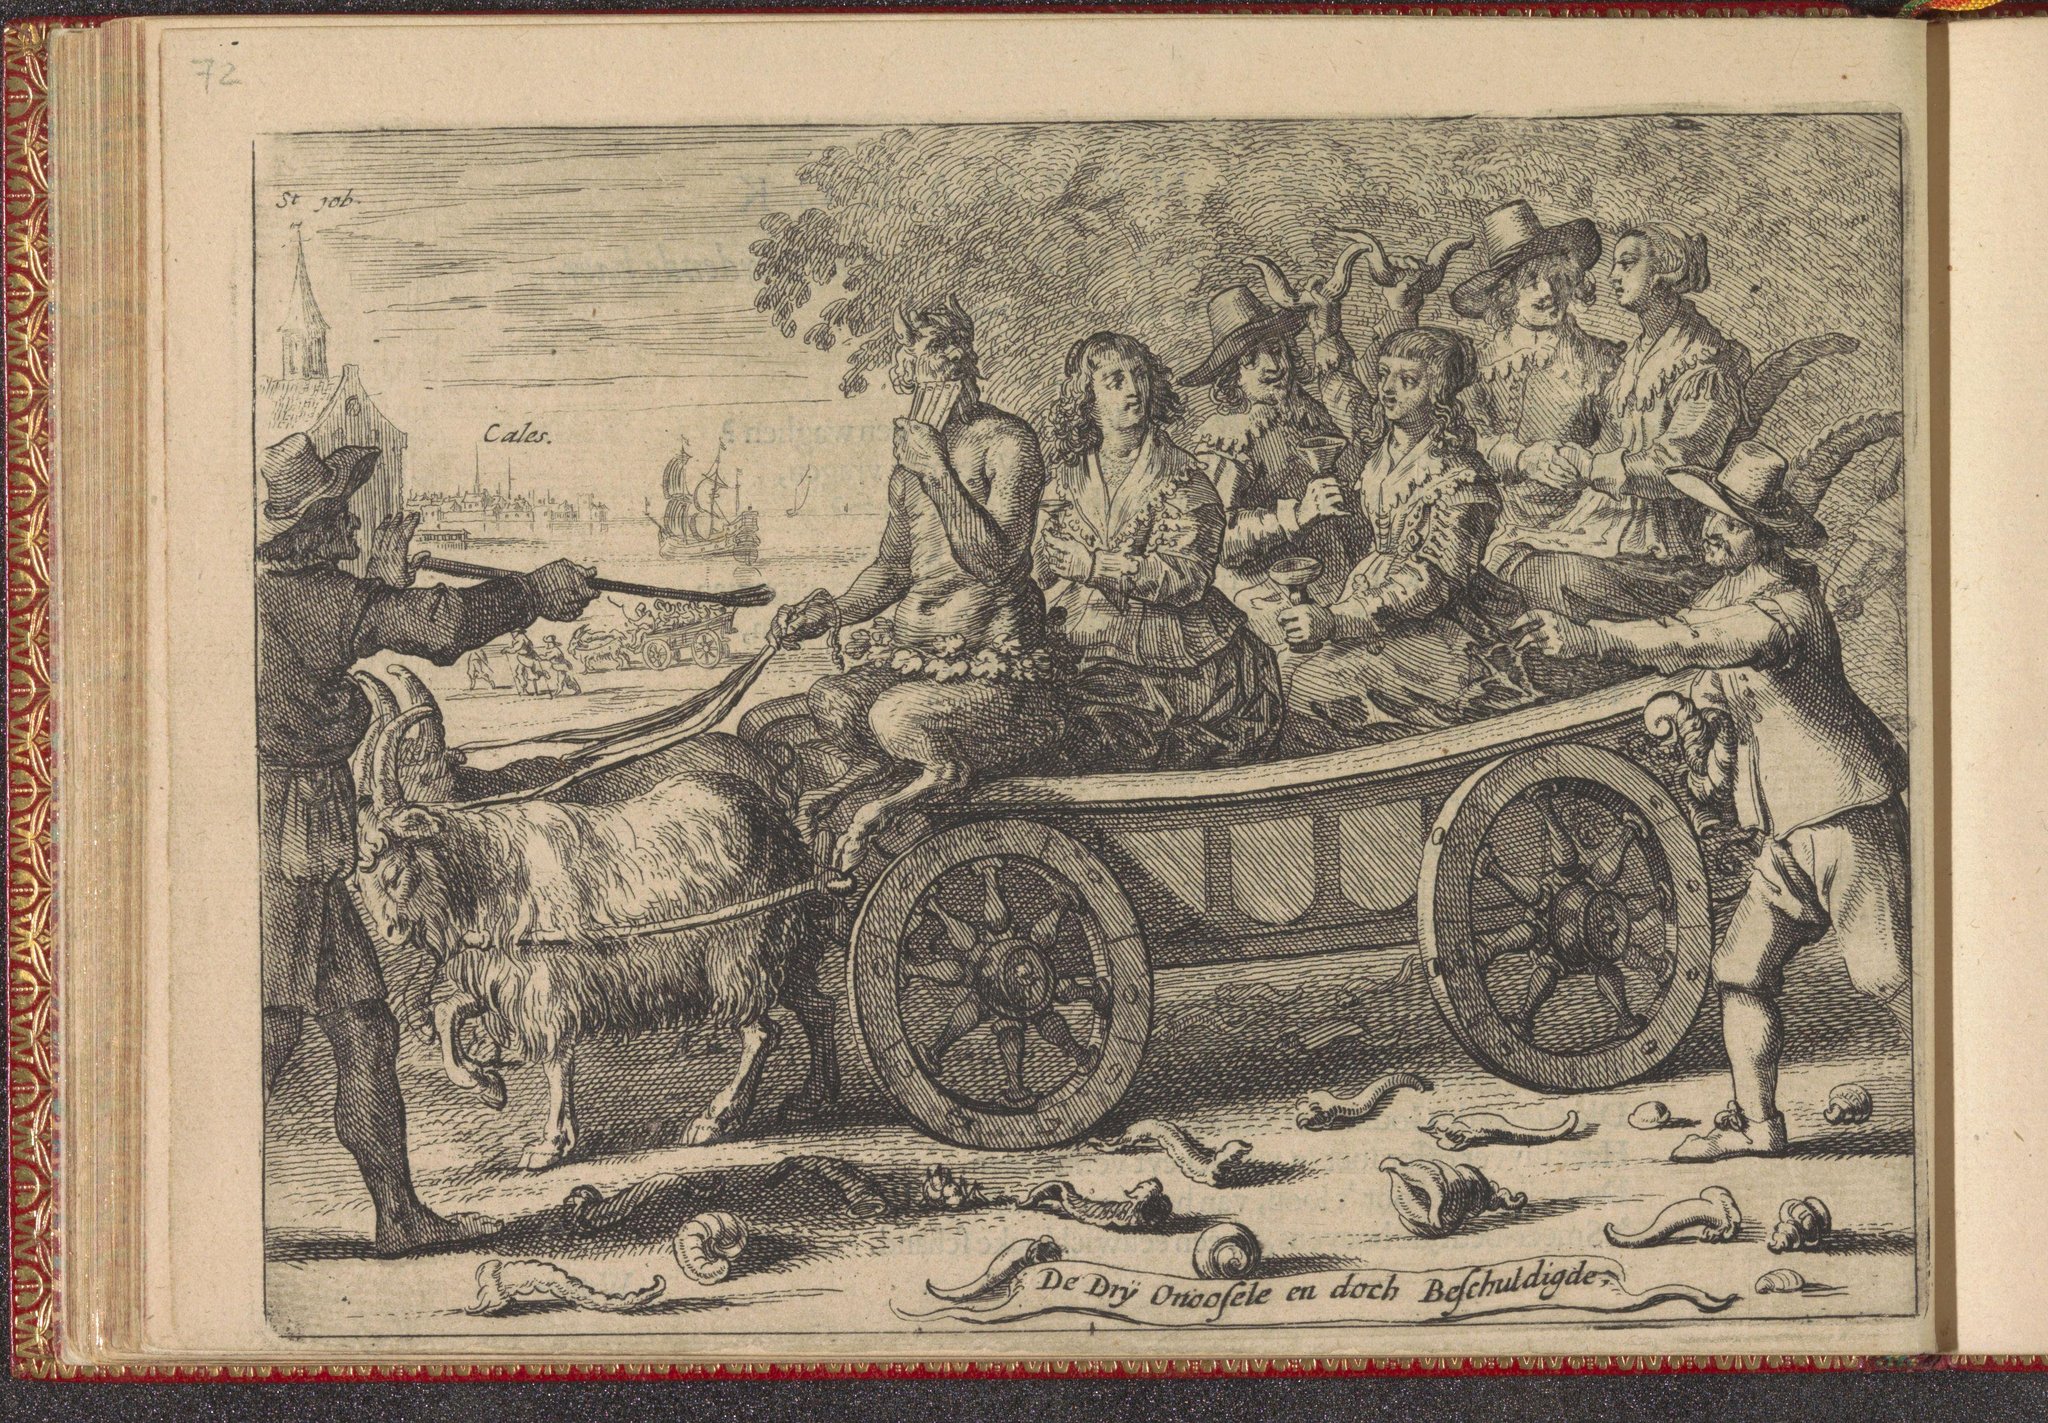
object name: titelprent, frontispice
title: De drye onnosele en doch beschuldigde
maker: crispijn van de passe (ii)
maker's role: draughtsman, print maker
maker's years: 1594-1670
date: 1641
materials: paper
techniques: engraving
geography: amsterdam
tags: partner deceived, satyr(s) (in general), goat, four-wheeled vehicle drawn by two animals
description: Een wagen getrokken door twee geiten en aangestuurd door een sater rijdt over een weg bezaaid met horens. Achterin de wagen houden een dame en heer elkaars hand vast. Daarvoor een man en vrouw met de hoorn als symbool van de bedrogen echtegenoot. De voorste vrouw kijkt achterom naar de man naast de wagen. Links probeert een andere man de wagen tegen te houden. Op de achtergrond nog een wagen getrokken door twee geiten. In de verte verder enkele schepen, een stadsgezicht (Calis) en een gasthuis genaamd Sint Job. De prent maakt deel uit van een album.